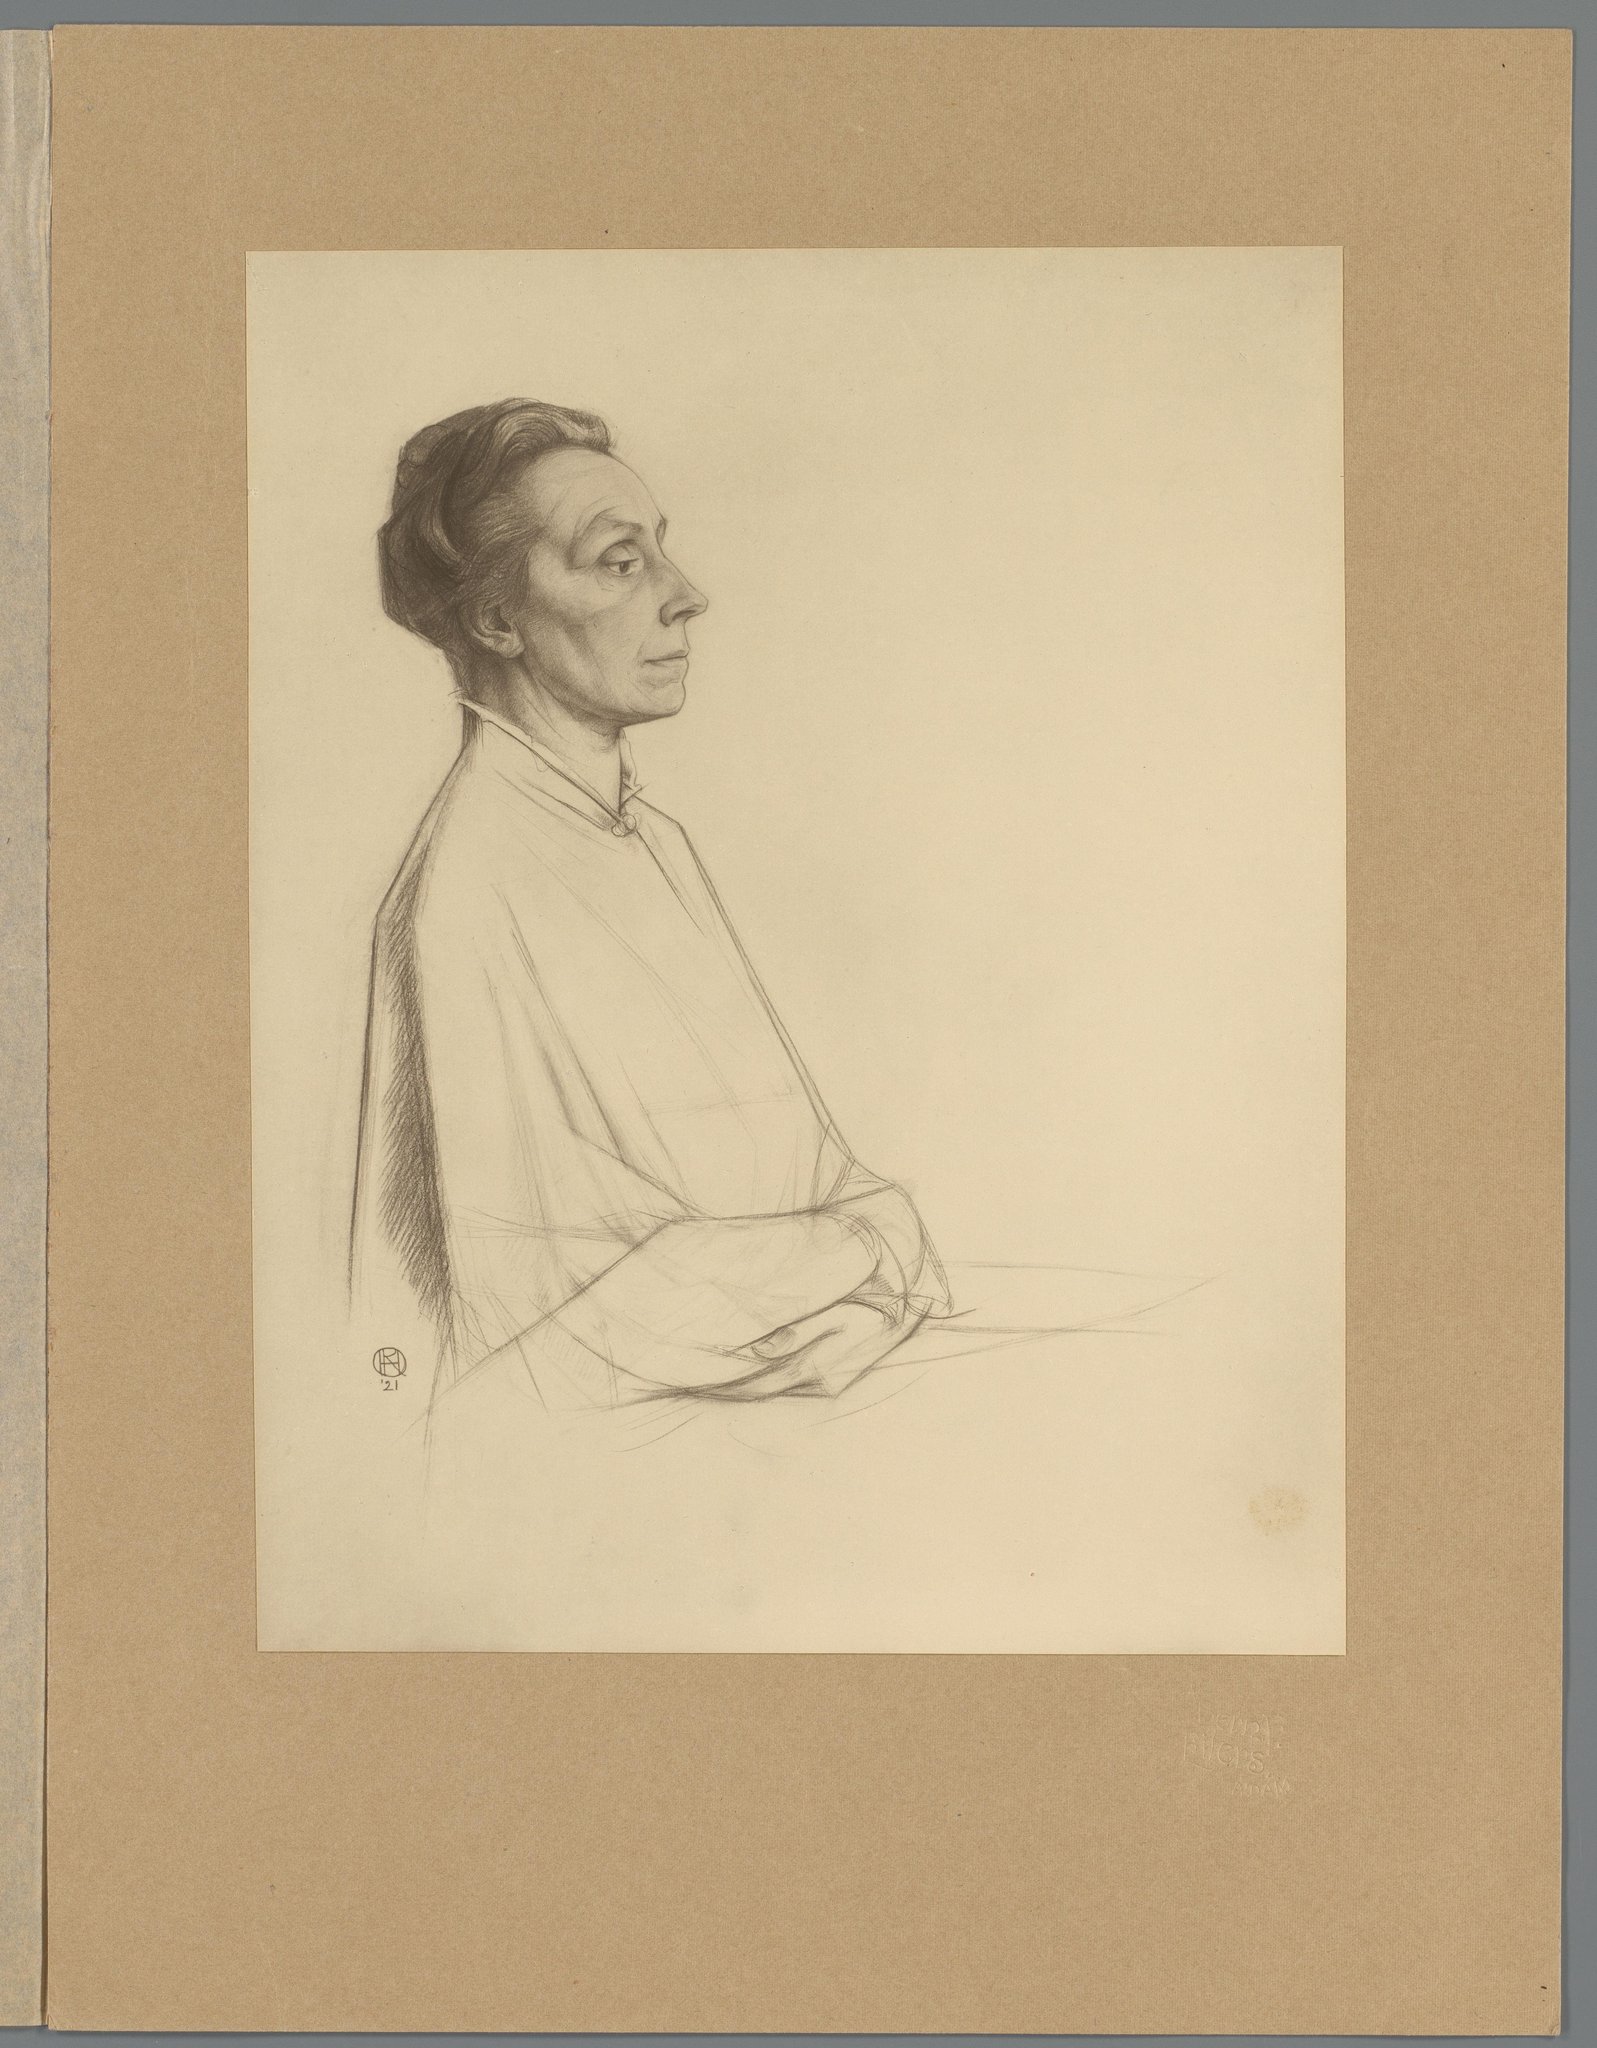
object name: reproduction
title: Fotoreproductie van een getekend portret van Henriëtte Roland Holst-van der Schalk door Richard Nicolaüs Roland Holst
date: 1921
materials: paper, cardboard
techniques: gelatin silver print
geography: amsterdam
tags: henriëtte roland holst-van der schalk, historical persons - bb - woman, writer, poet, author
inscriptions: check stamp: ‘Bernh./ Eilers/ A'dam’, inscription: ‘R.N. Roland Holst/ Foto naar portret van Jet (1921)/ onb. eg 63./ lijst reproducties no. XXI’